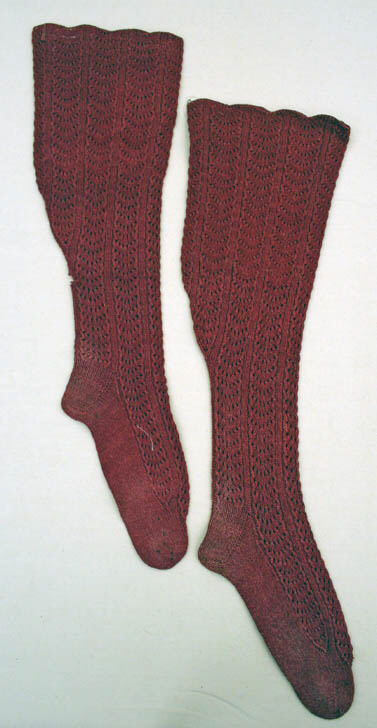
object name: stocking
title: Stockings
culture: american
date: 1801-1900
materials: cotton